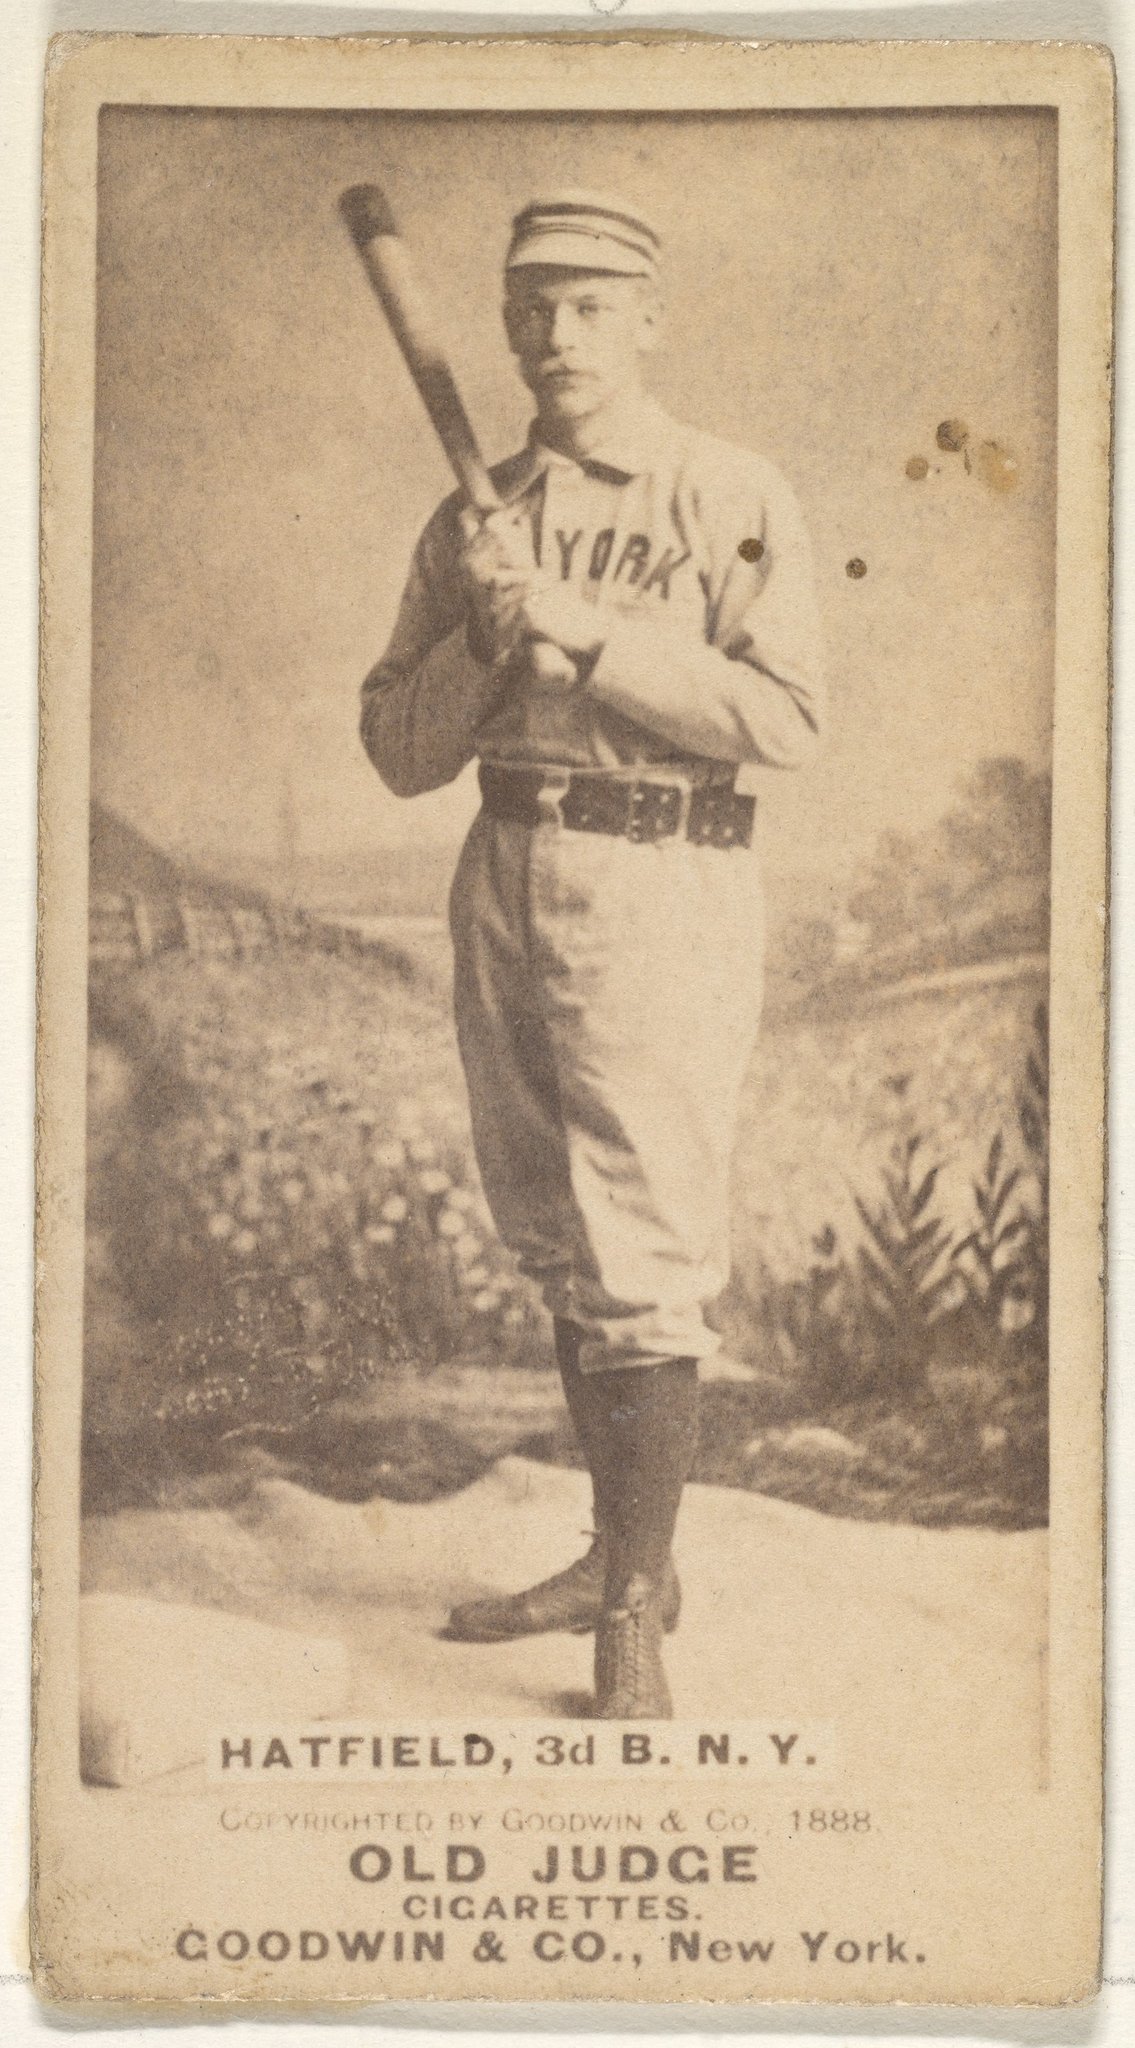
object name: baseball card, photograph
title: Gil Hatfield, 3rd Base, New York, from the Old Judge series (N172) for Old Judge Cigarettes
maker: goodwin & company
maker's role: publisher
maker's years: 1850-1950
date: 1888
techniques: albumen silver print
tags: men,portraits,baseball,athletes